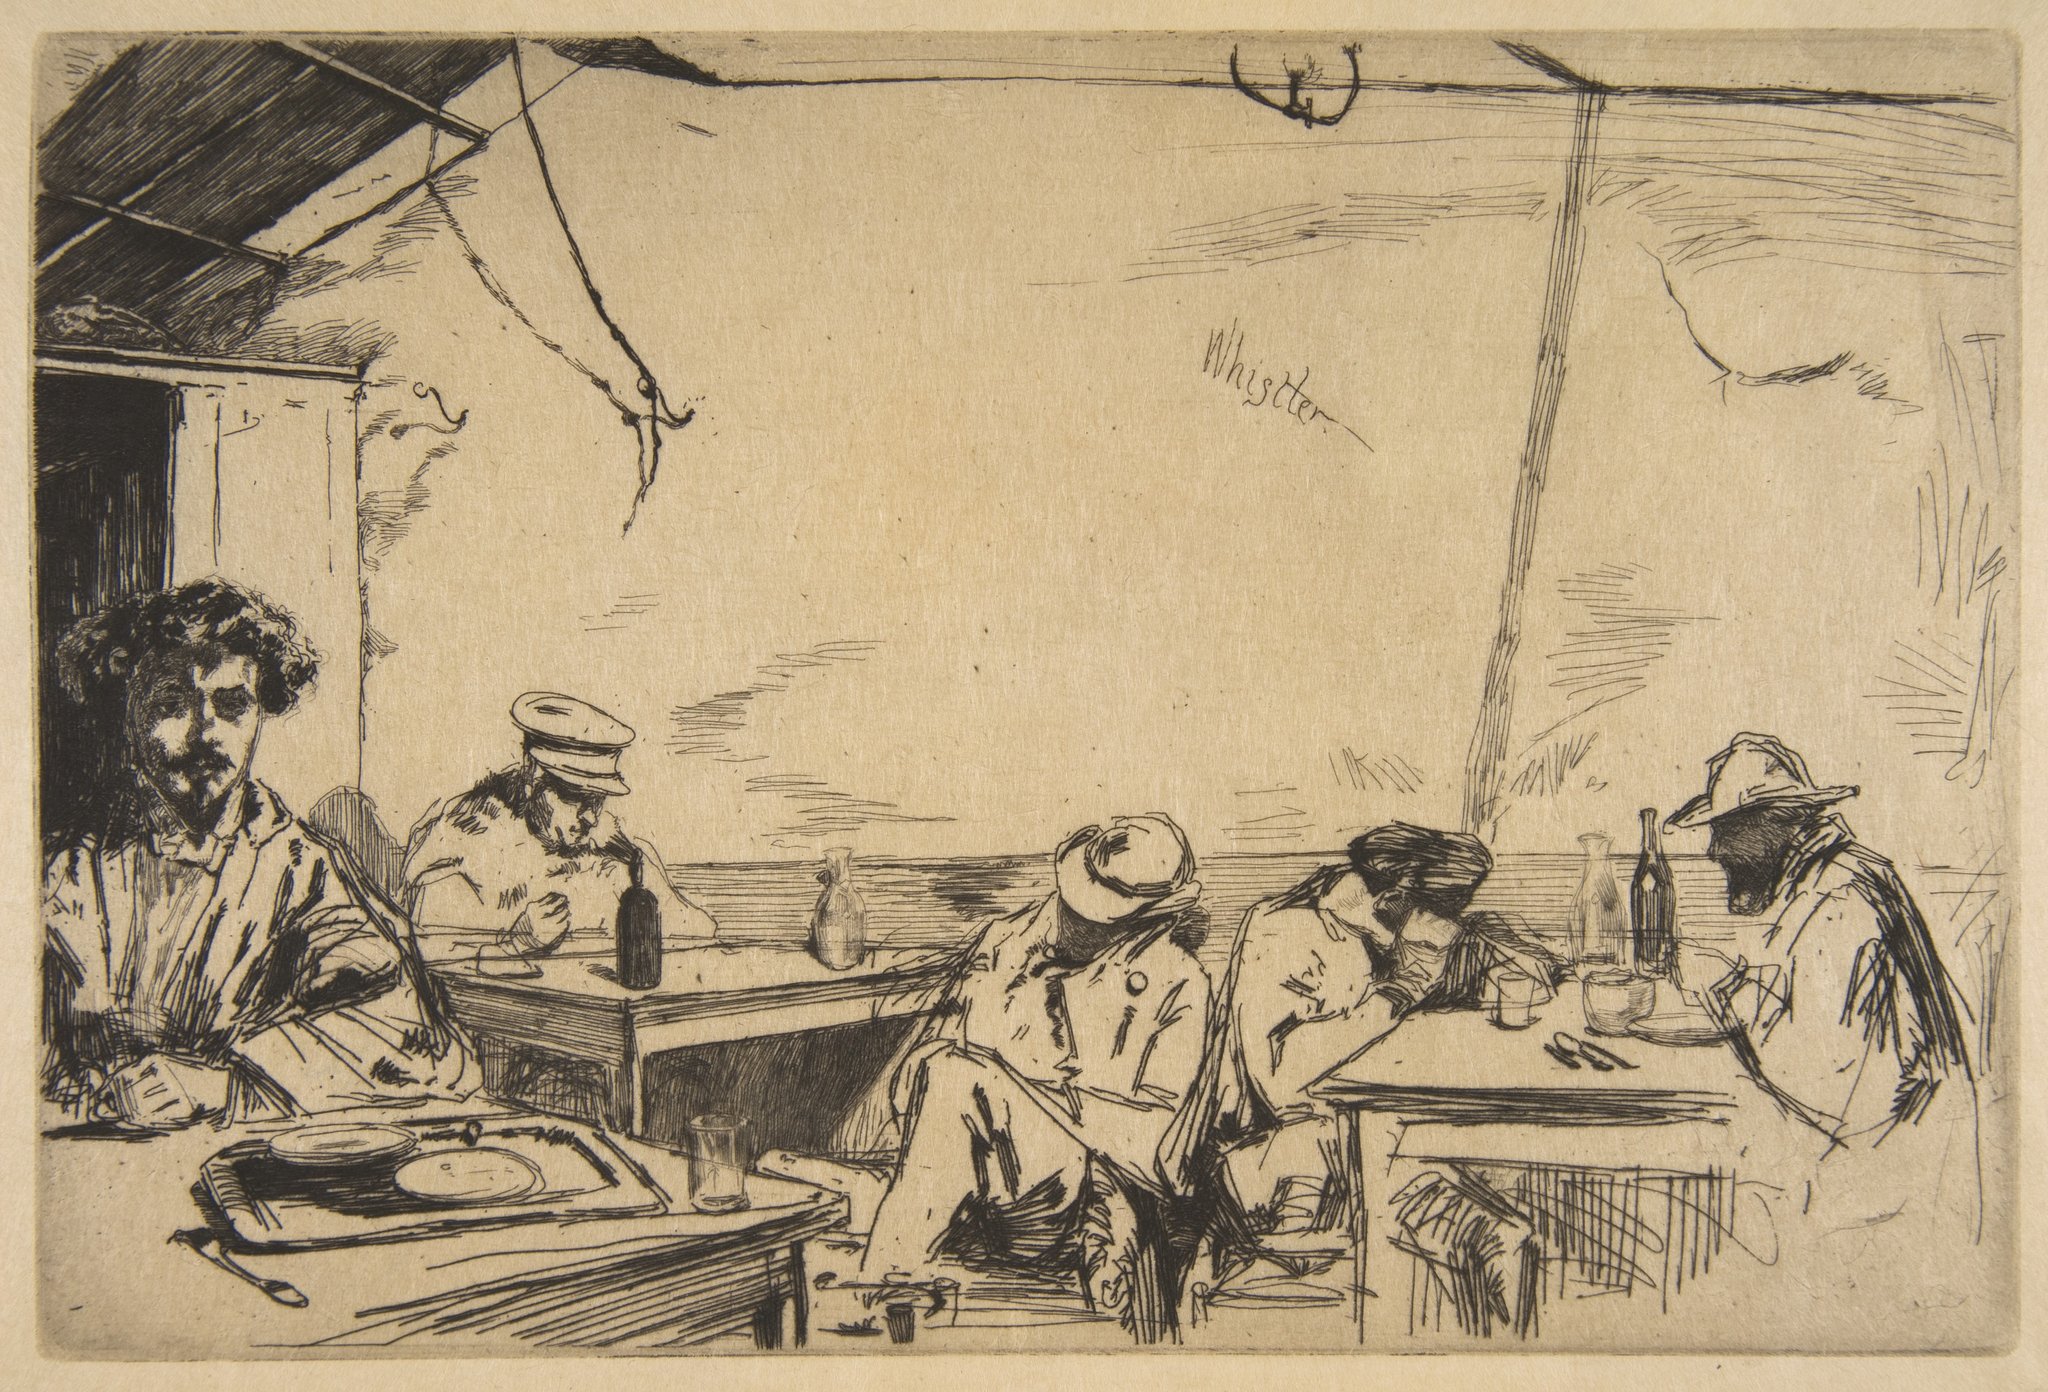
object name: print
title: Soupe à trois sous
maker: james mcneill whistler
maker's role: artist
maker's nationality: american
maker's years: 1834-1903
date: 1859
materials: ink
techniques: etching, printing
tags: men,drinking,bottles,tables